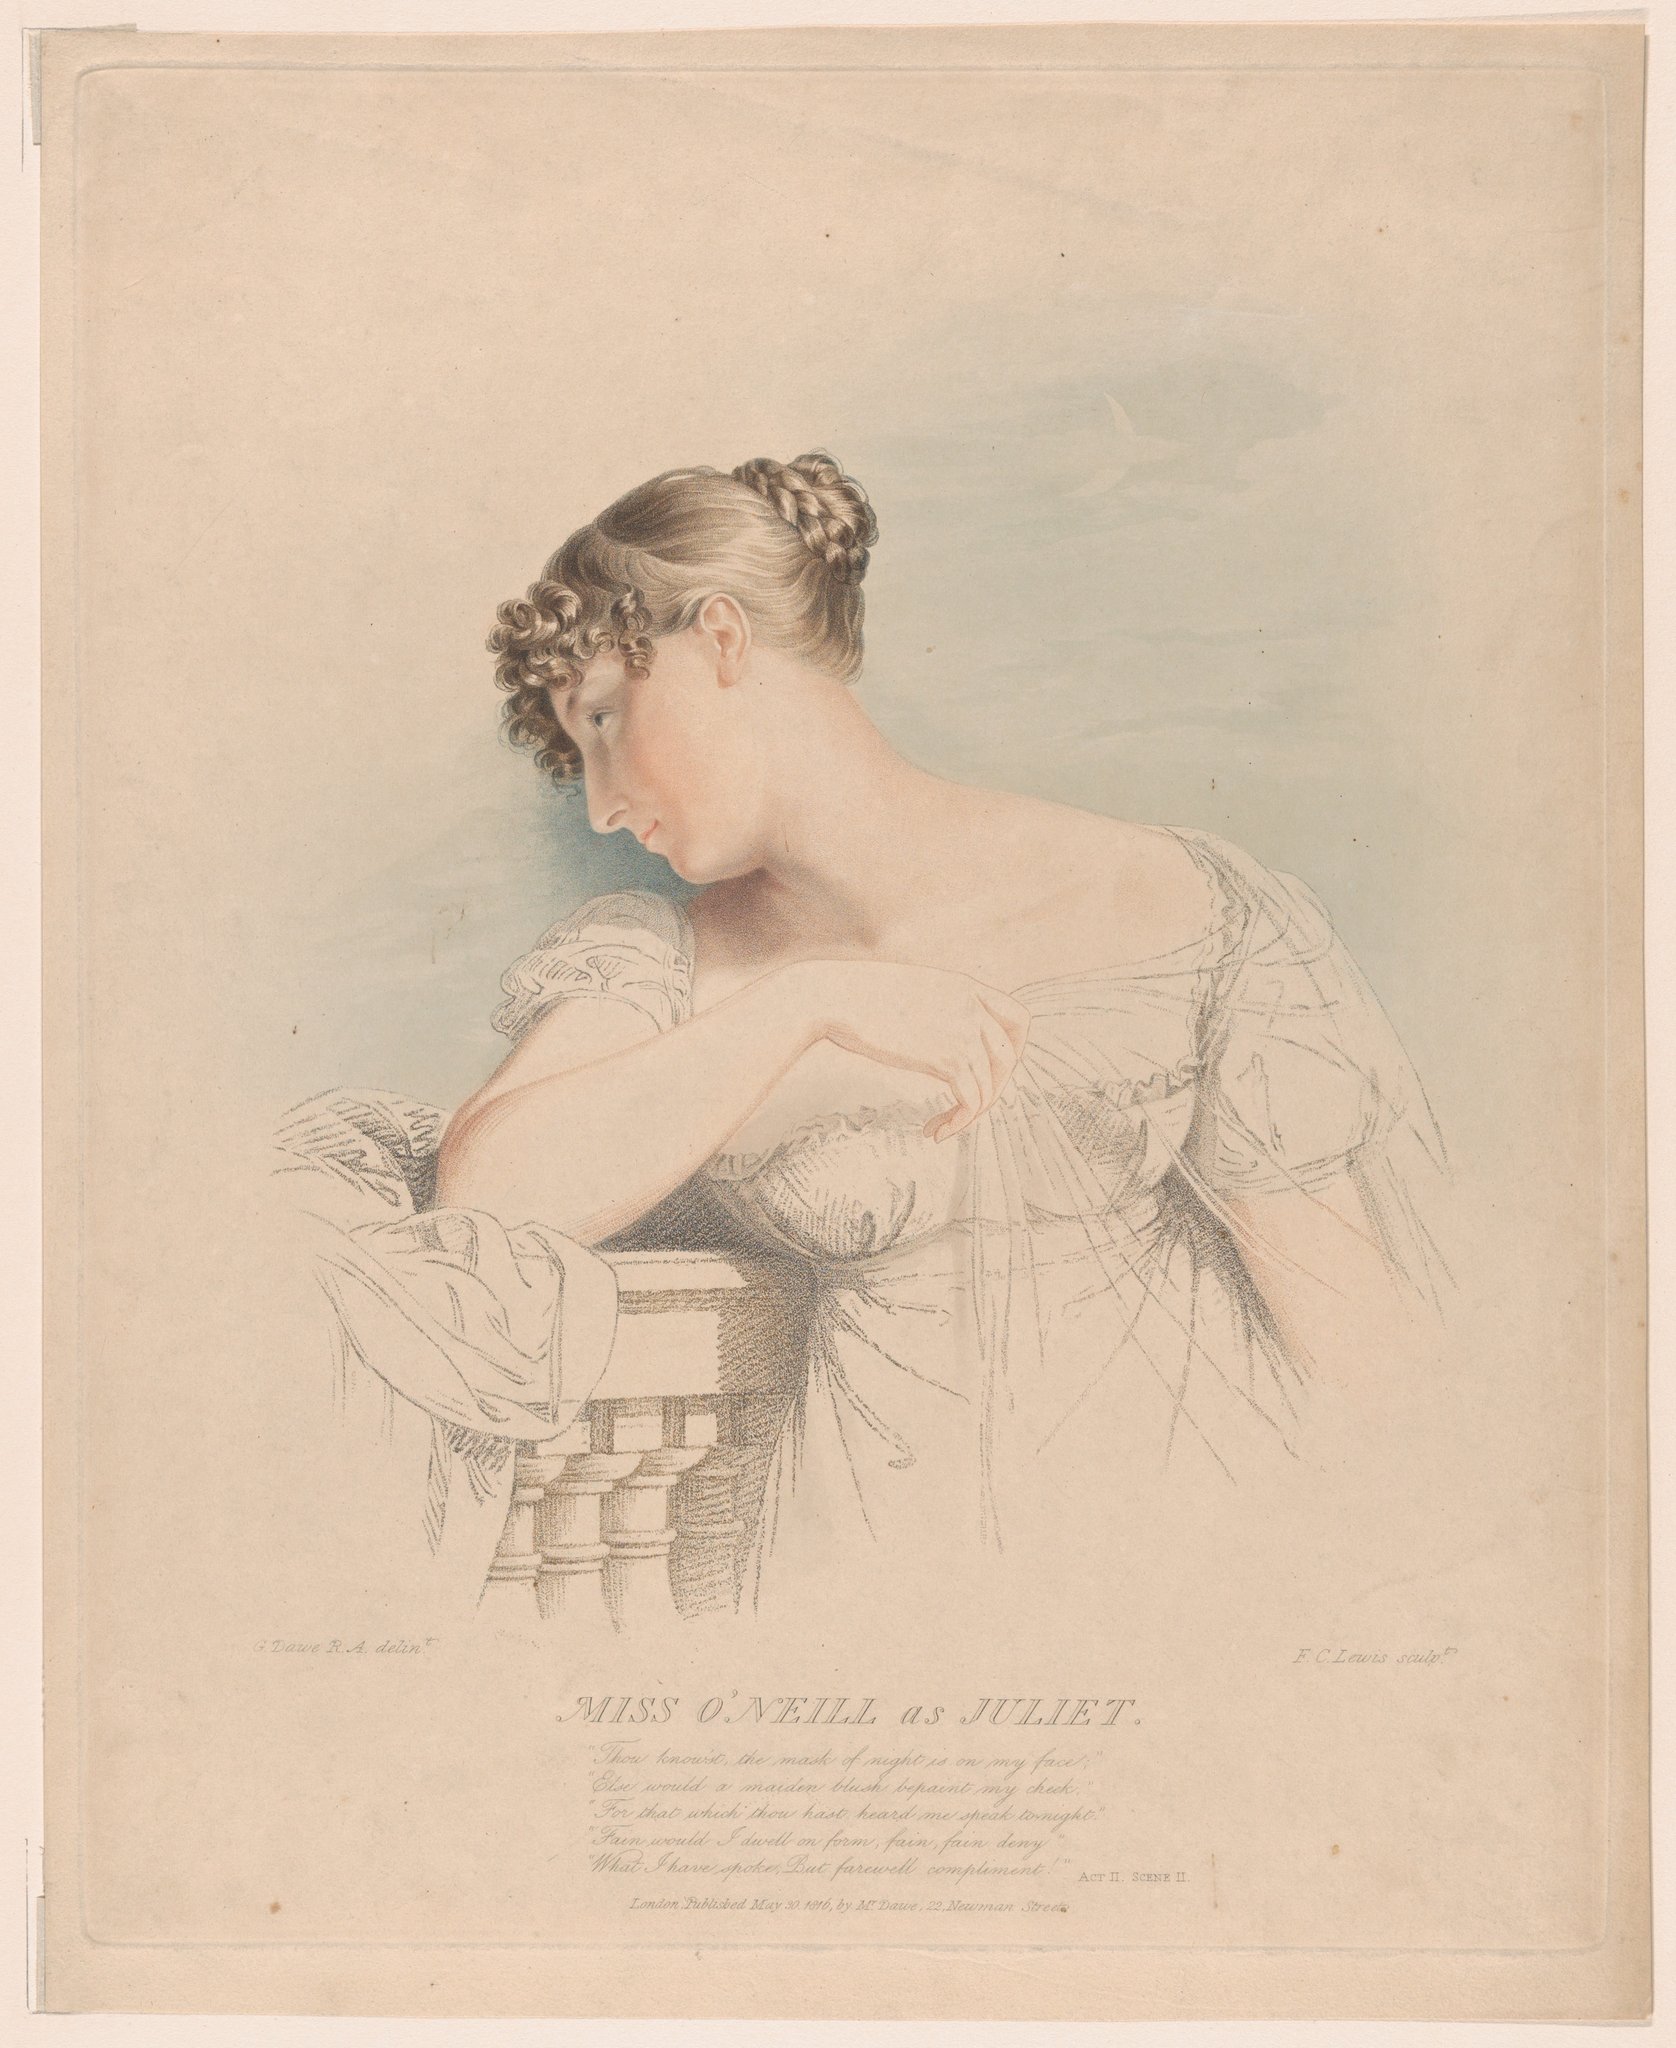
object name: print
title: Miss O'Neill as Juliet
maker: george dawe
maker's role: artist and publisher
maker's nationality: british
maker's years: 1781-1829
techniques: printing, etching, engraving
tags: shakespeare,women,actresses